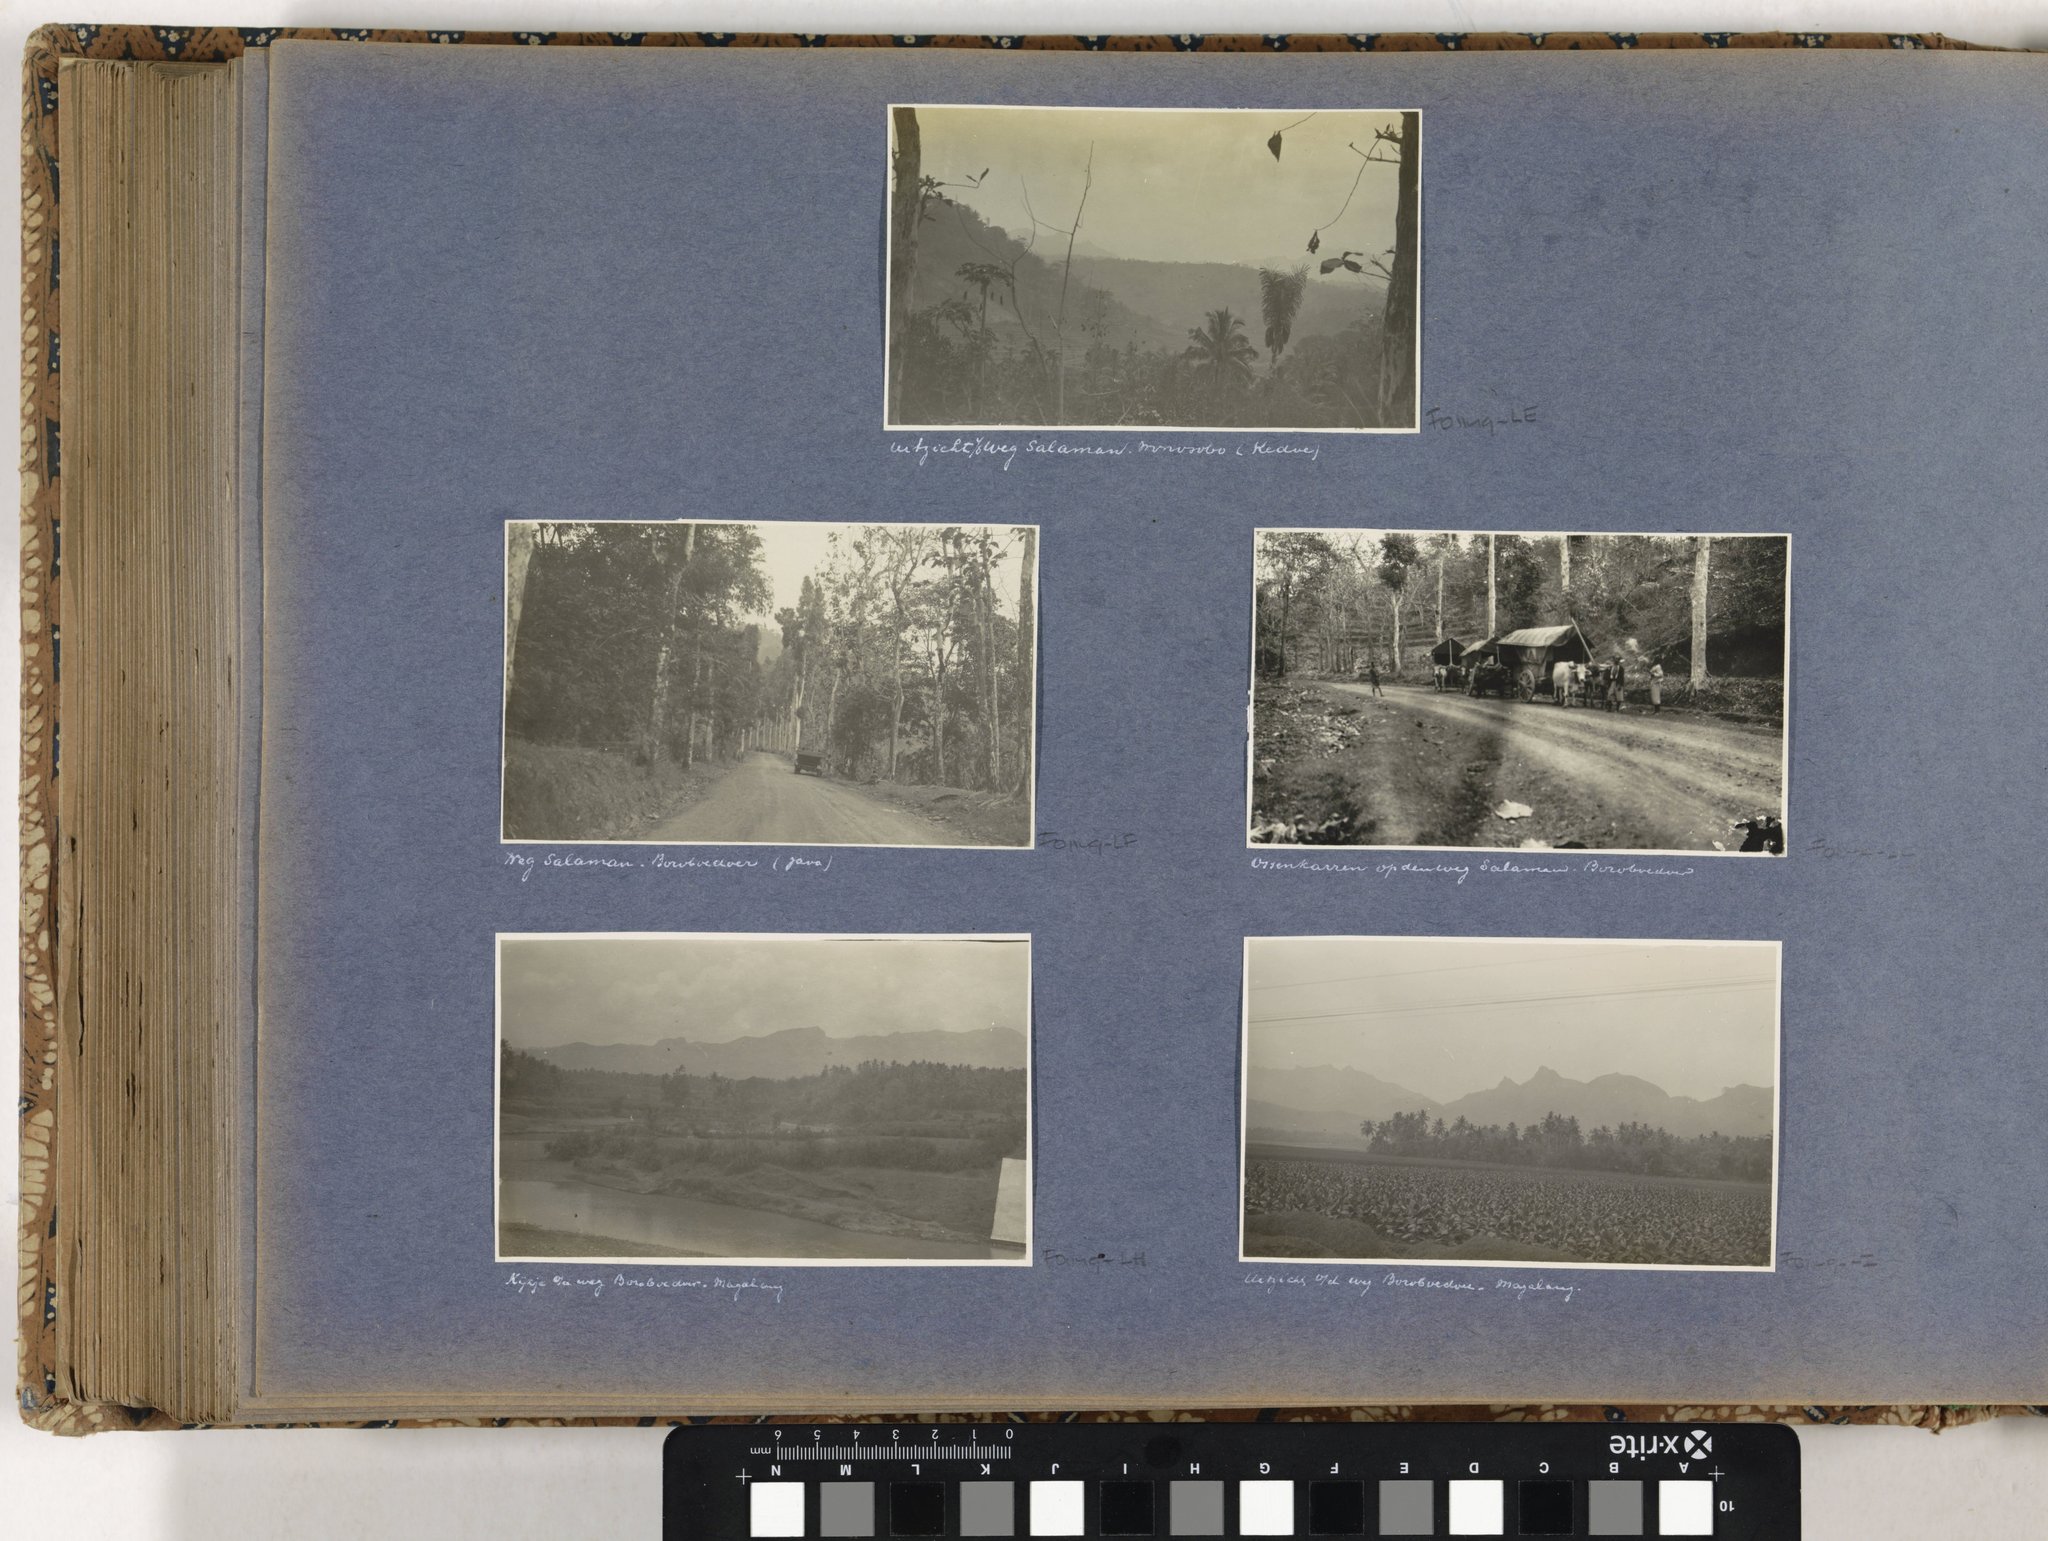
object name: album leaf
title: Auto op de weg van Salaman naar Borobudur op Java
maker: Anonymous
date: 1900-1920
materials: paper, photographic support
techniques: gelatin silver print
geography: java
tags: road, path, automobile, java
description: Onderdeel van reisalbum met foto's van bedrijvigheid en bezienswaardigheden op Sumatra en Java en van de reis naar en van Nederlands-Indië.